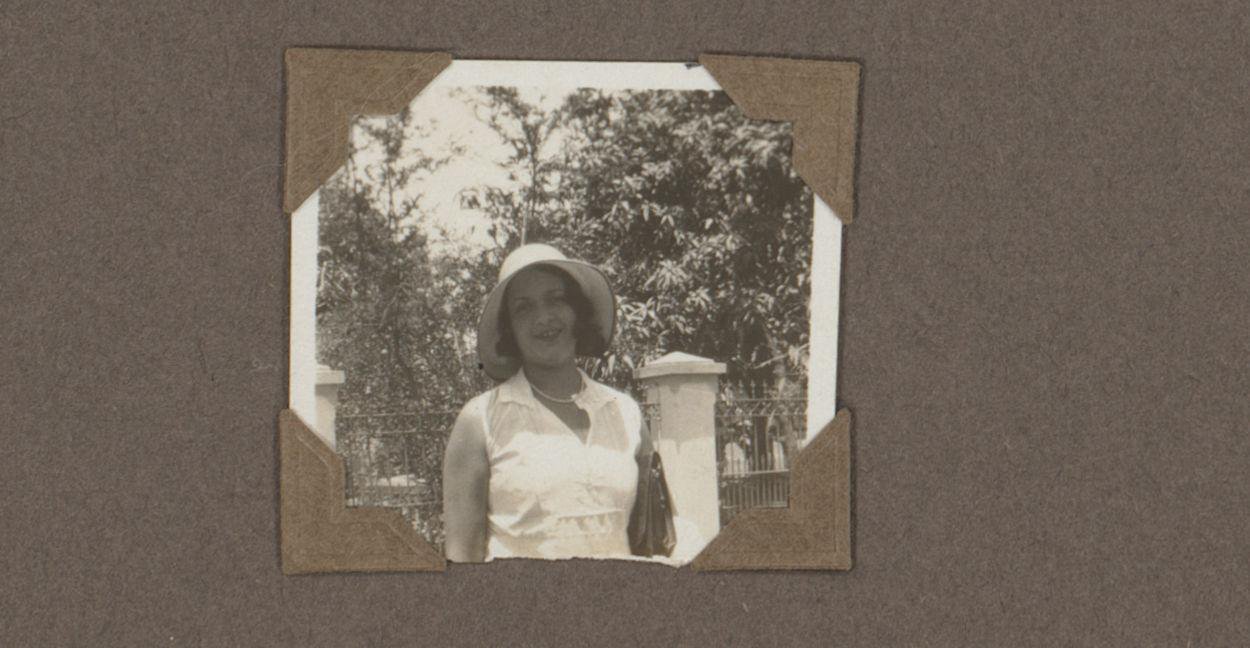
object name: photograph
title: Portret van Wilhelmina van Zijll de Jong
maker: Anonymous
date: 1930-1935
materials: paper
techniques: gelatin silver print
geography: dutch east indies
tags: the hague, wilhelmina van zijll de jong, adult woman, historical persons - bb - woman, dutch east indies, the